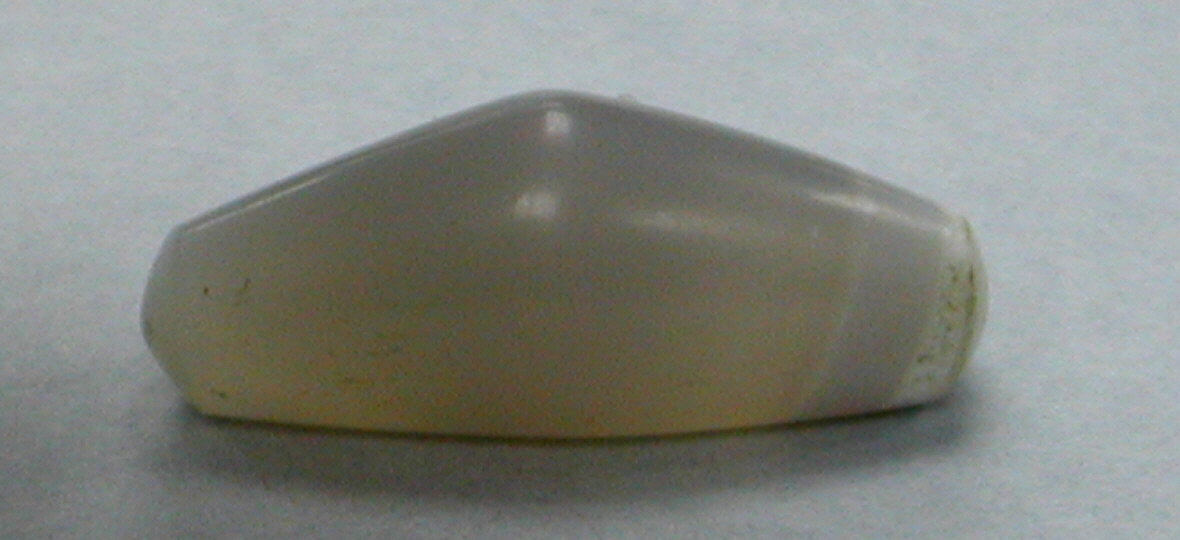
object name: ritual stone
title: Stone Pulidor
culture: mexican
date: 1501-1600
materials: stone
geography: mexico